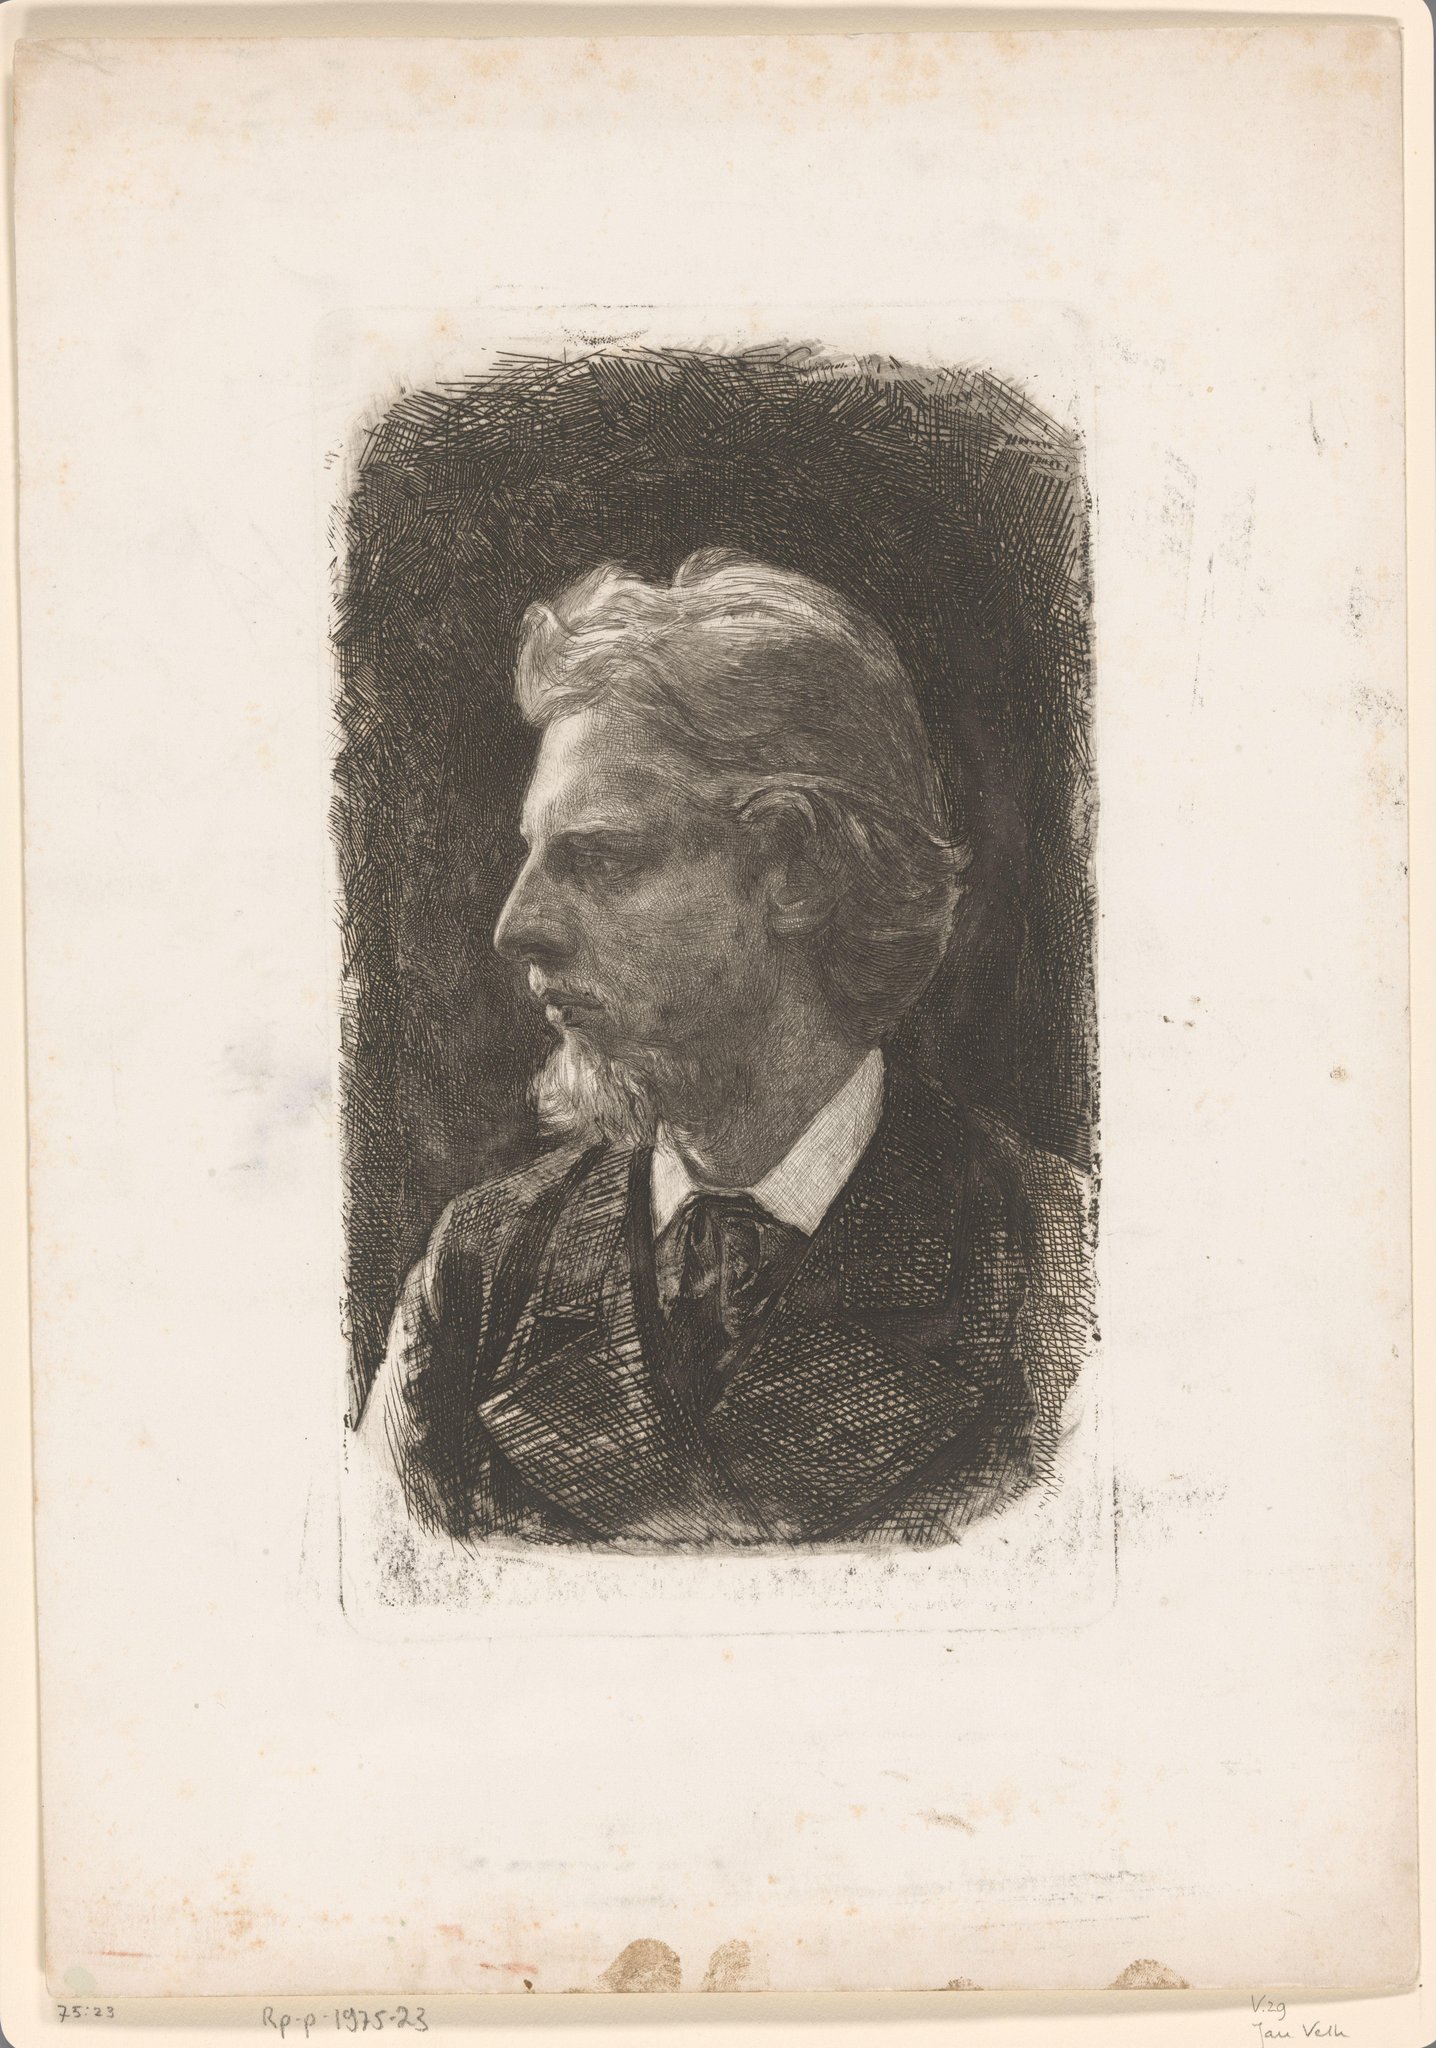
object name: print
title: Portret van Jacques Perk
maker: jan veth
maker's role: designer, draughtsman, painter, print maker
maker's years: 1864-1925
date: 1887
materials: paper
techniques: etching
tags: jacques perk, historical persons, writer, poet, author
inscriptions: collector's mark: Lugt 2228